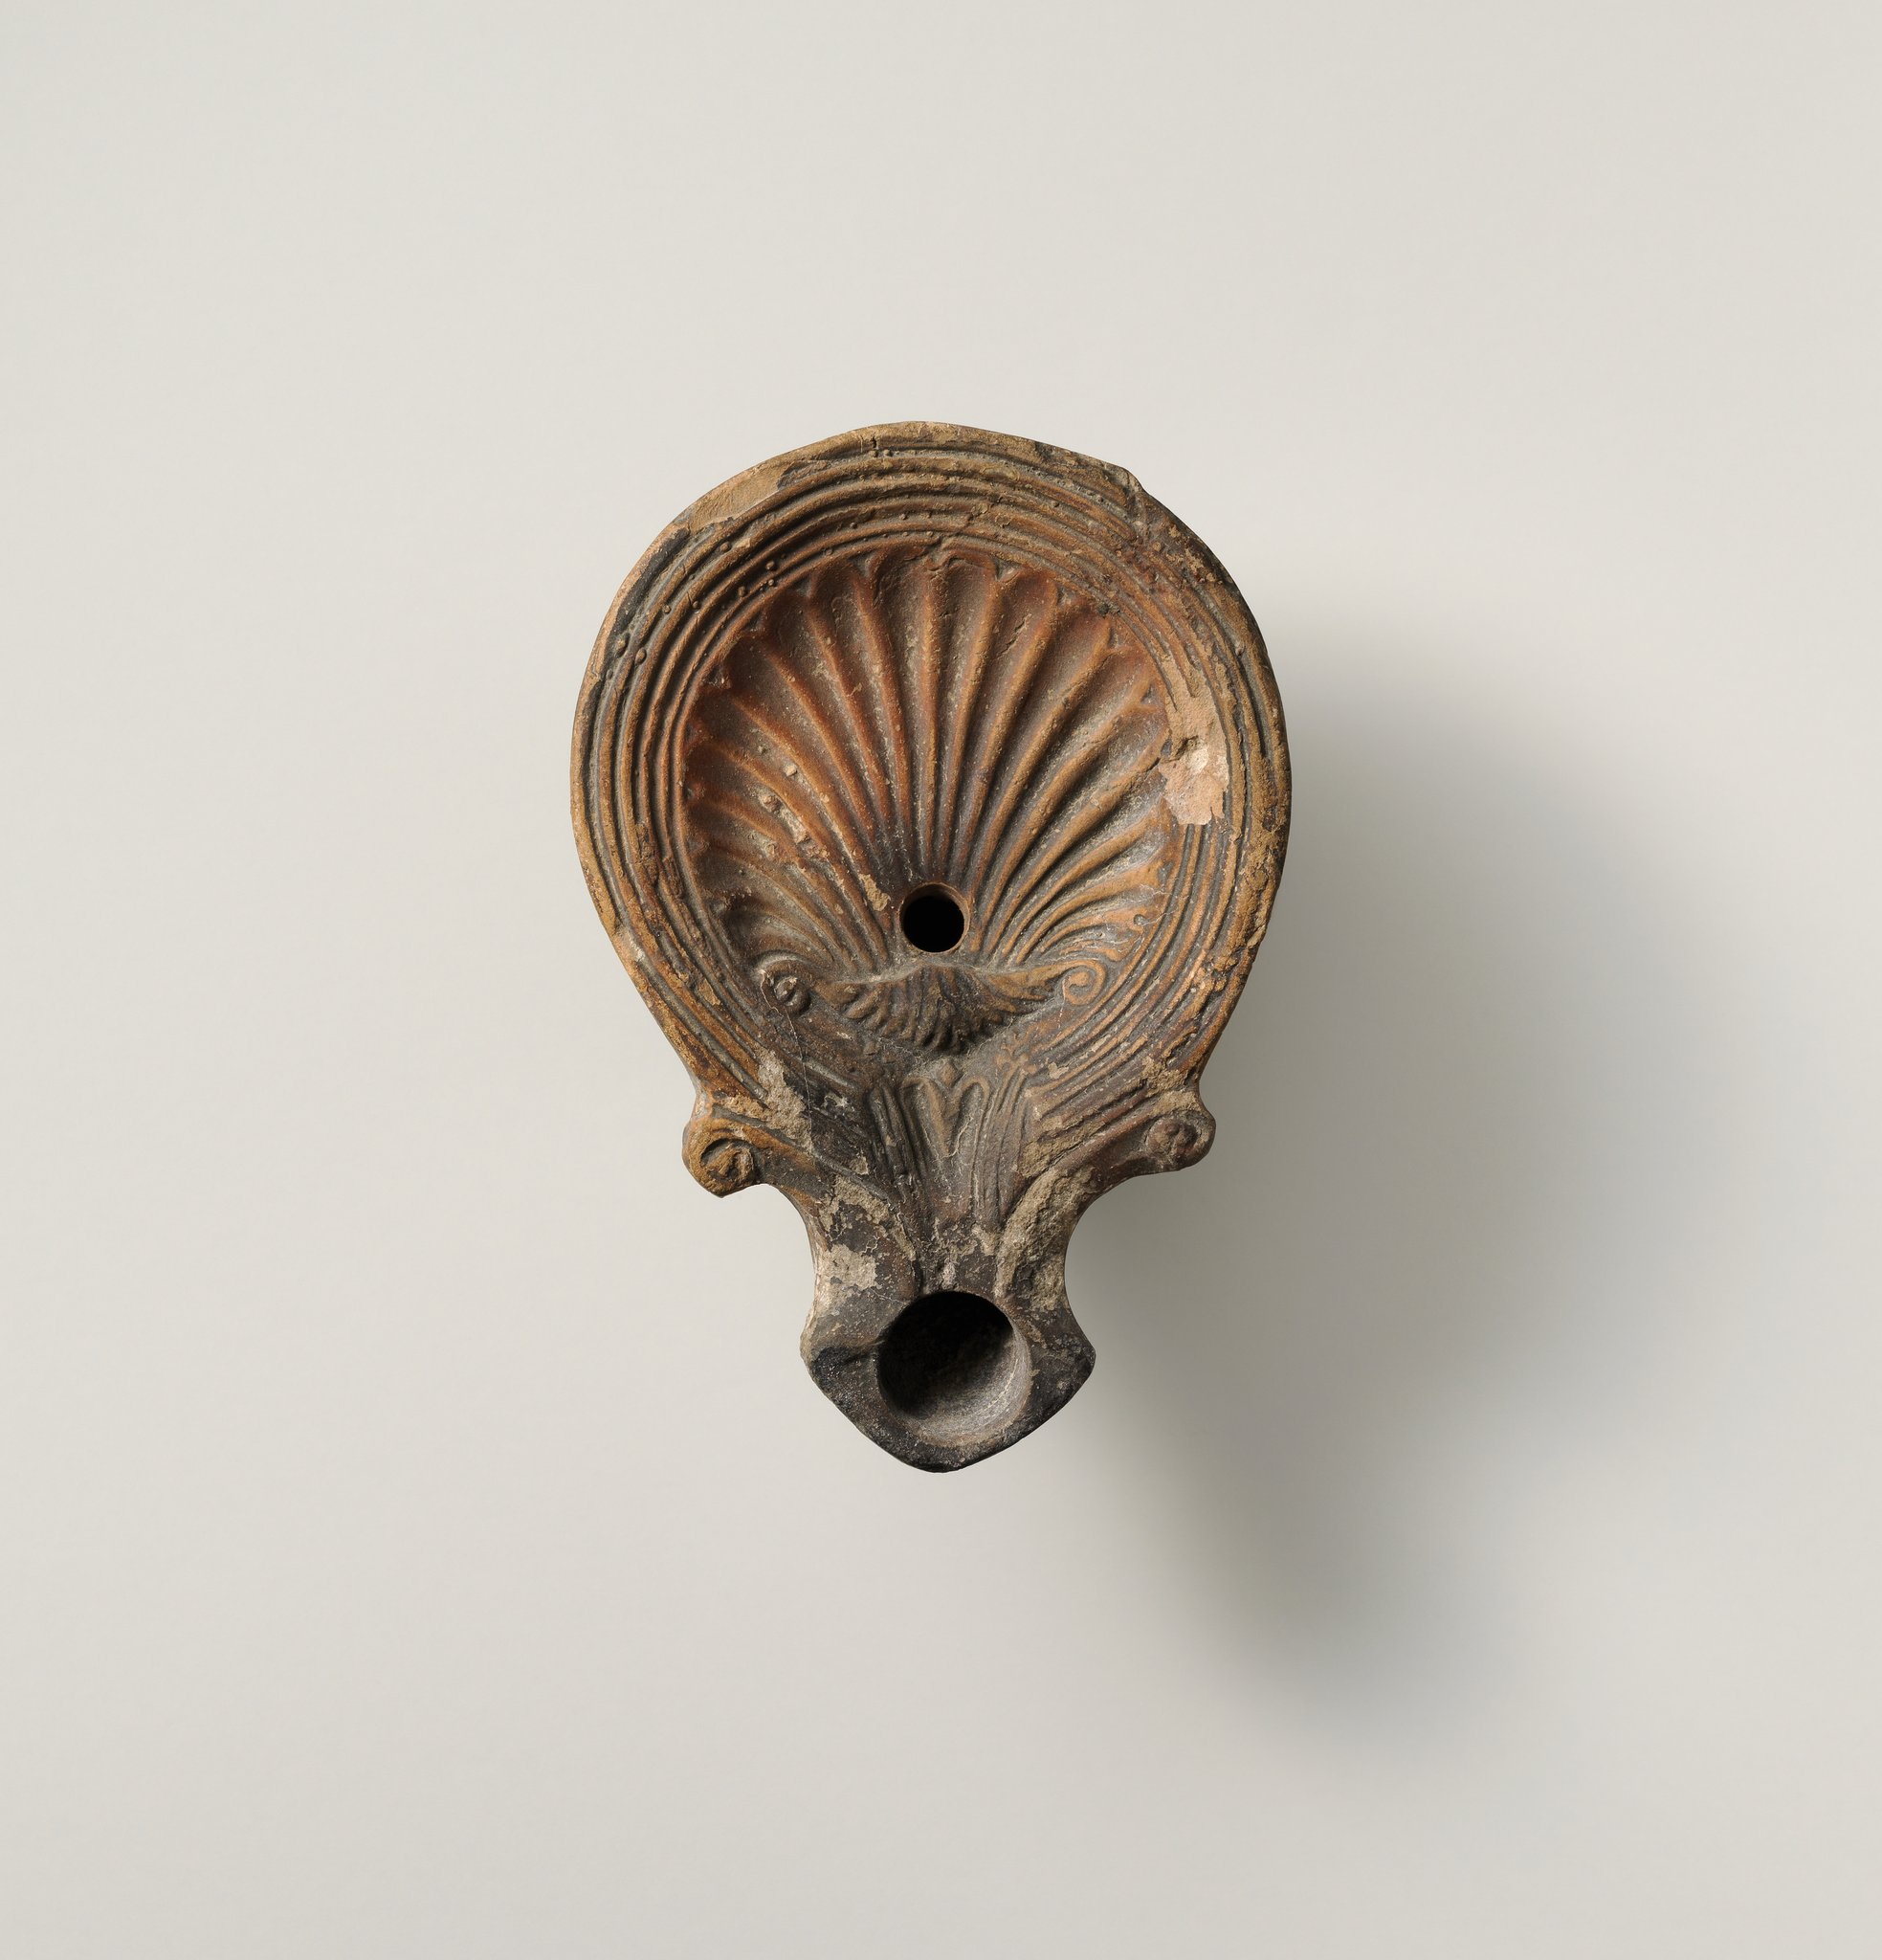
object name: lamp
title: Terracotta oil lamp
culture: roman, cypriot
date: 1-33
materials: terracotta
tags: shells